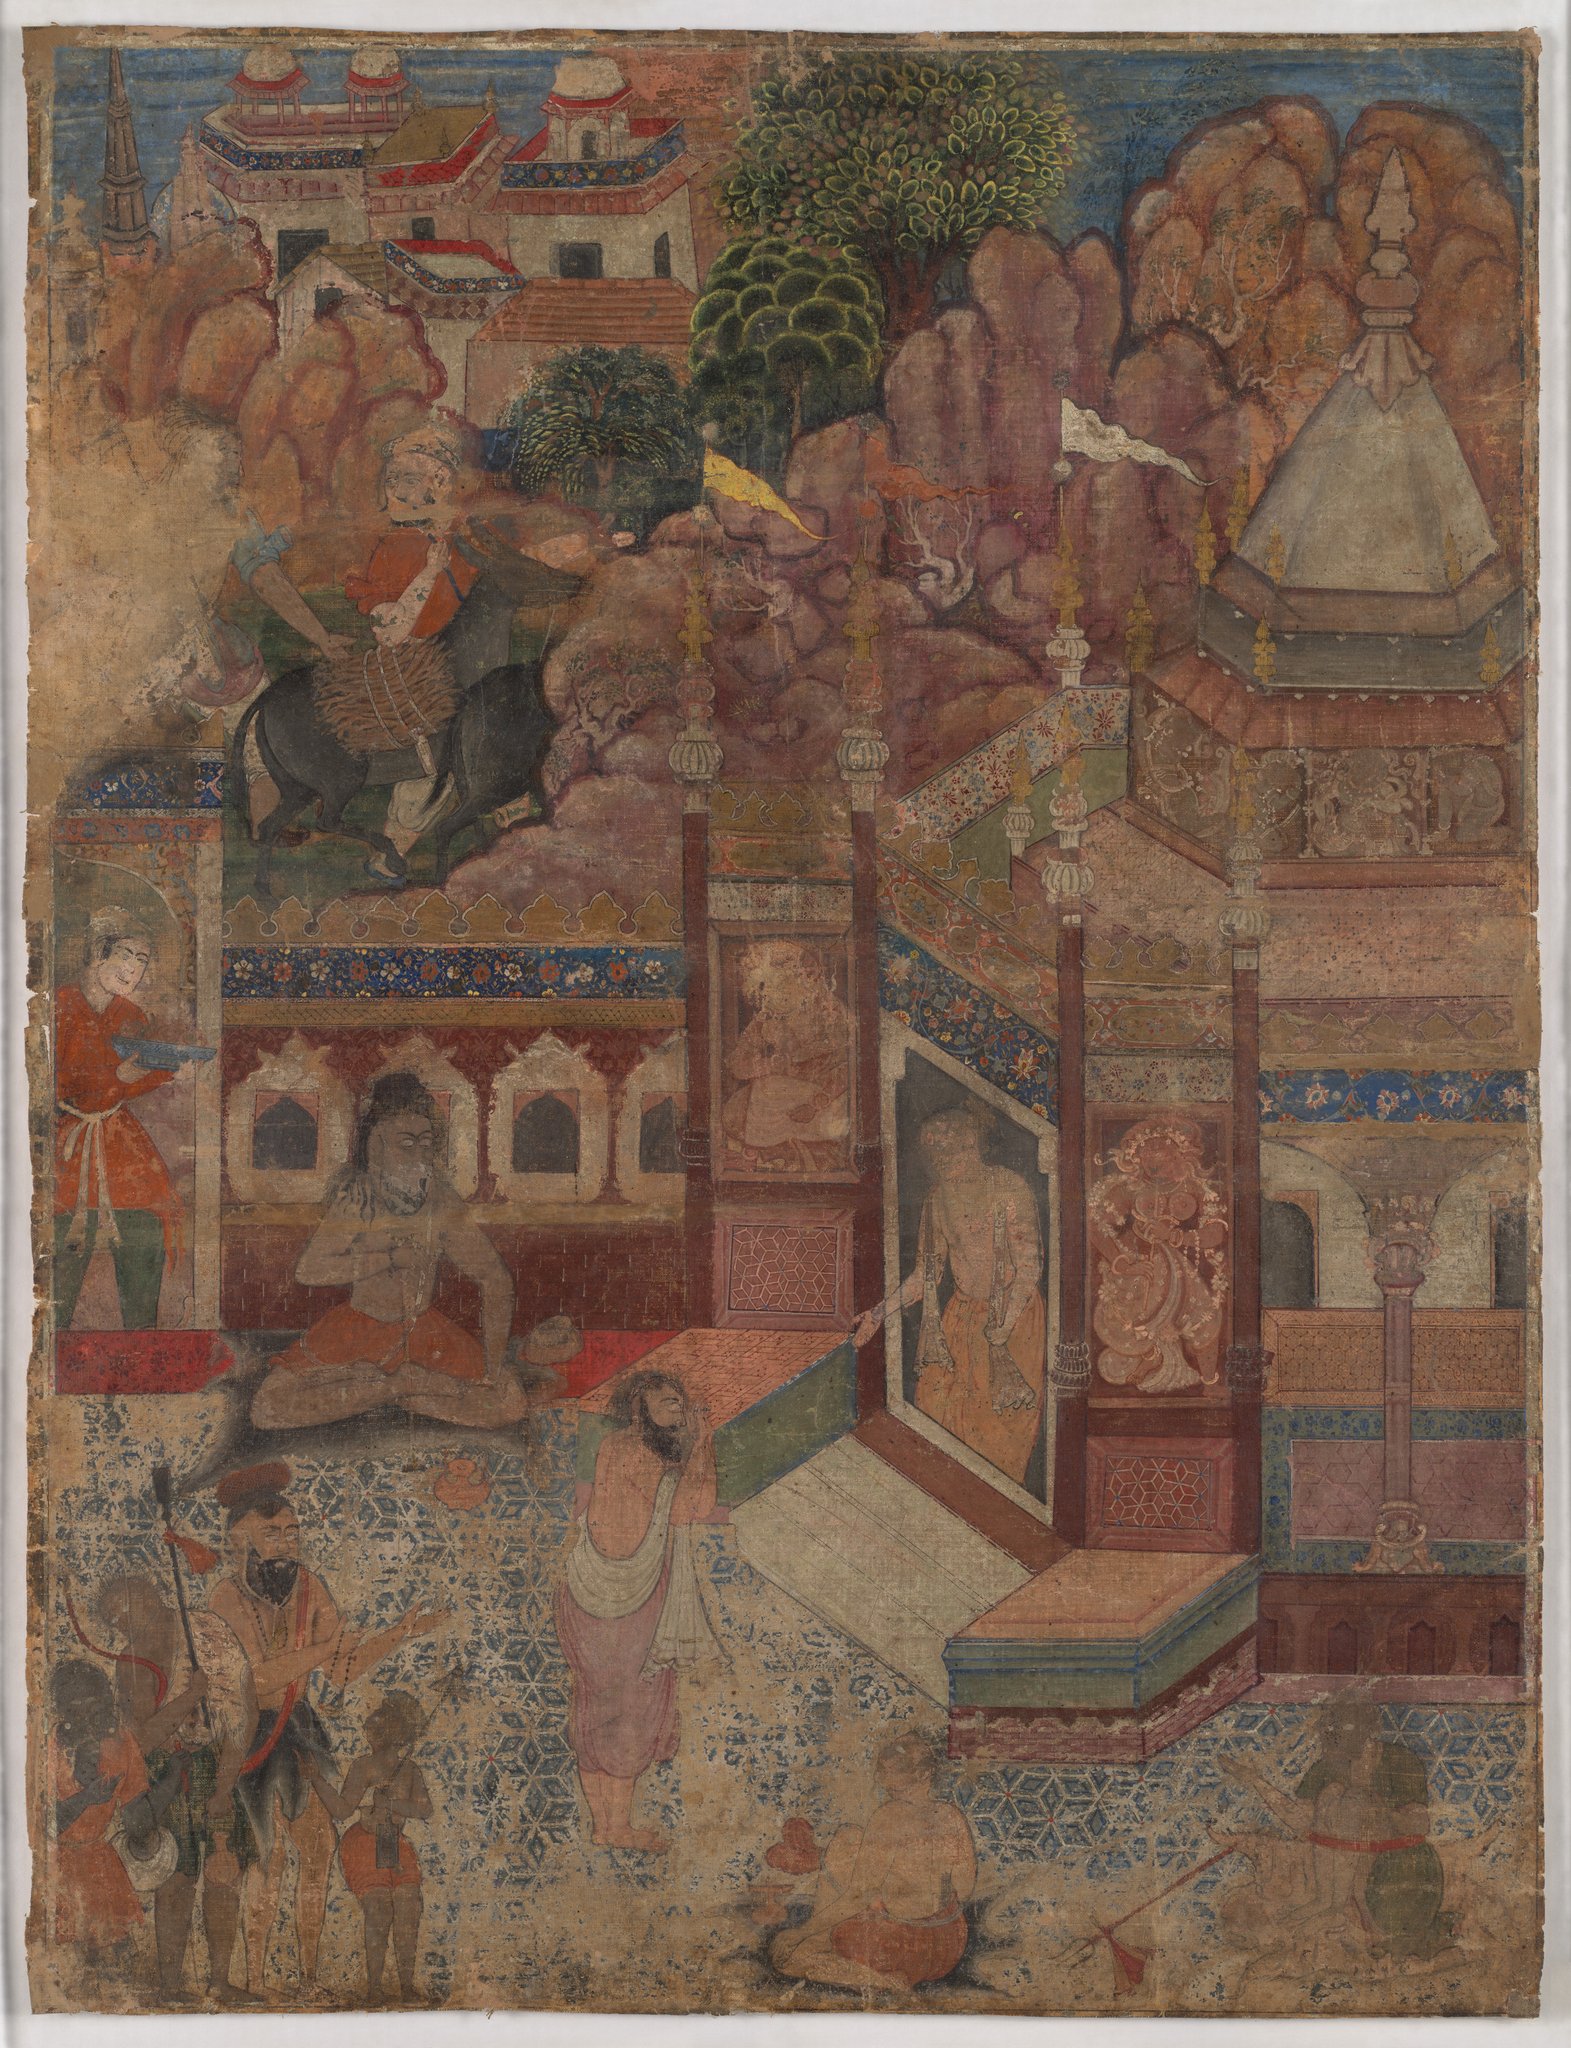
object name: folio from an illustrated manuscript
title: "A Supplicant at a Hindu Temple," Folio from the Hamzanama (The Adventures of Hamza)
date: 1570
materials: textile, cotton, gold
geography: india